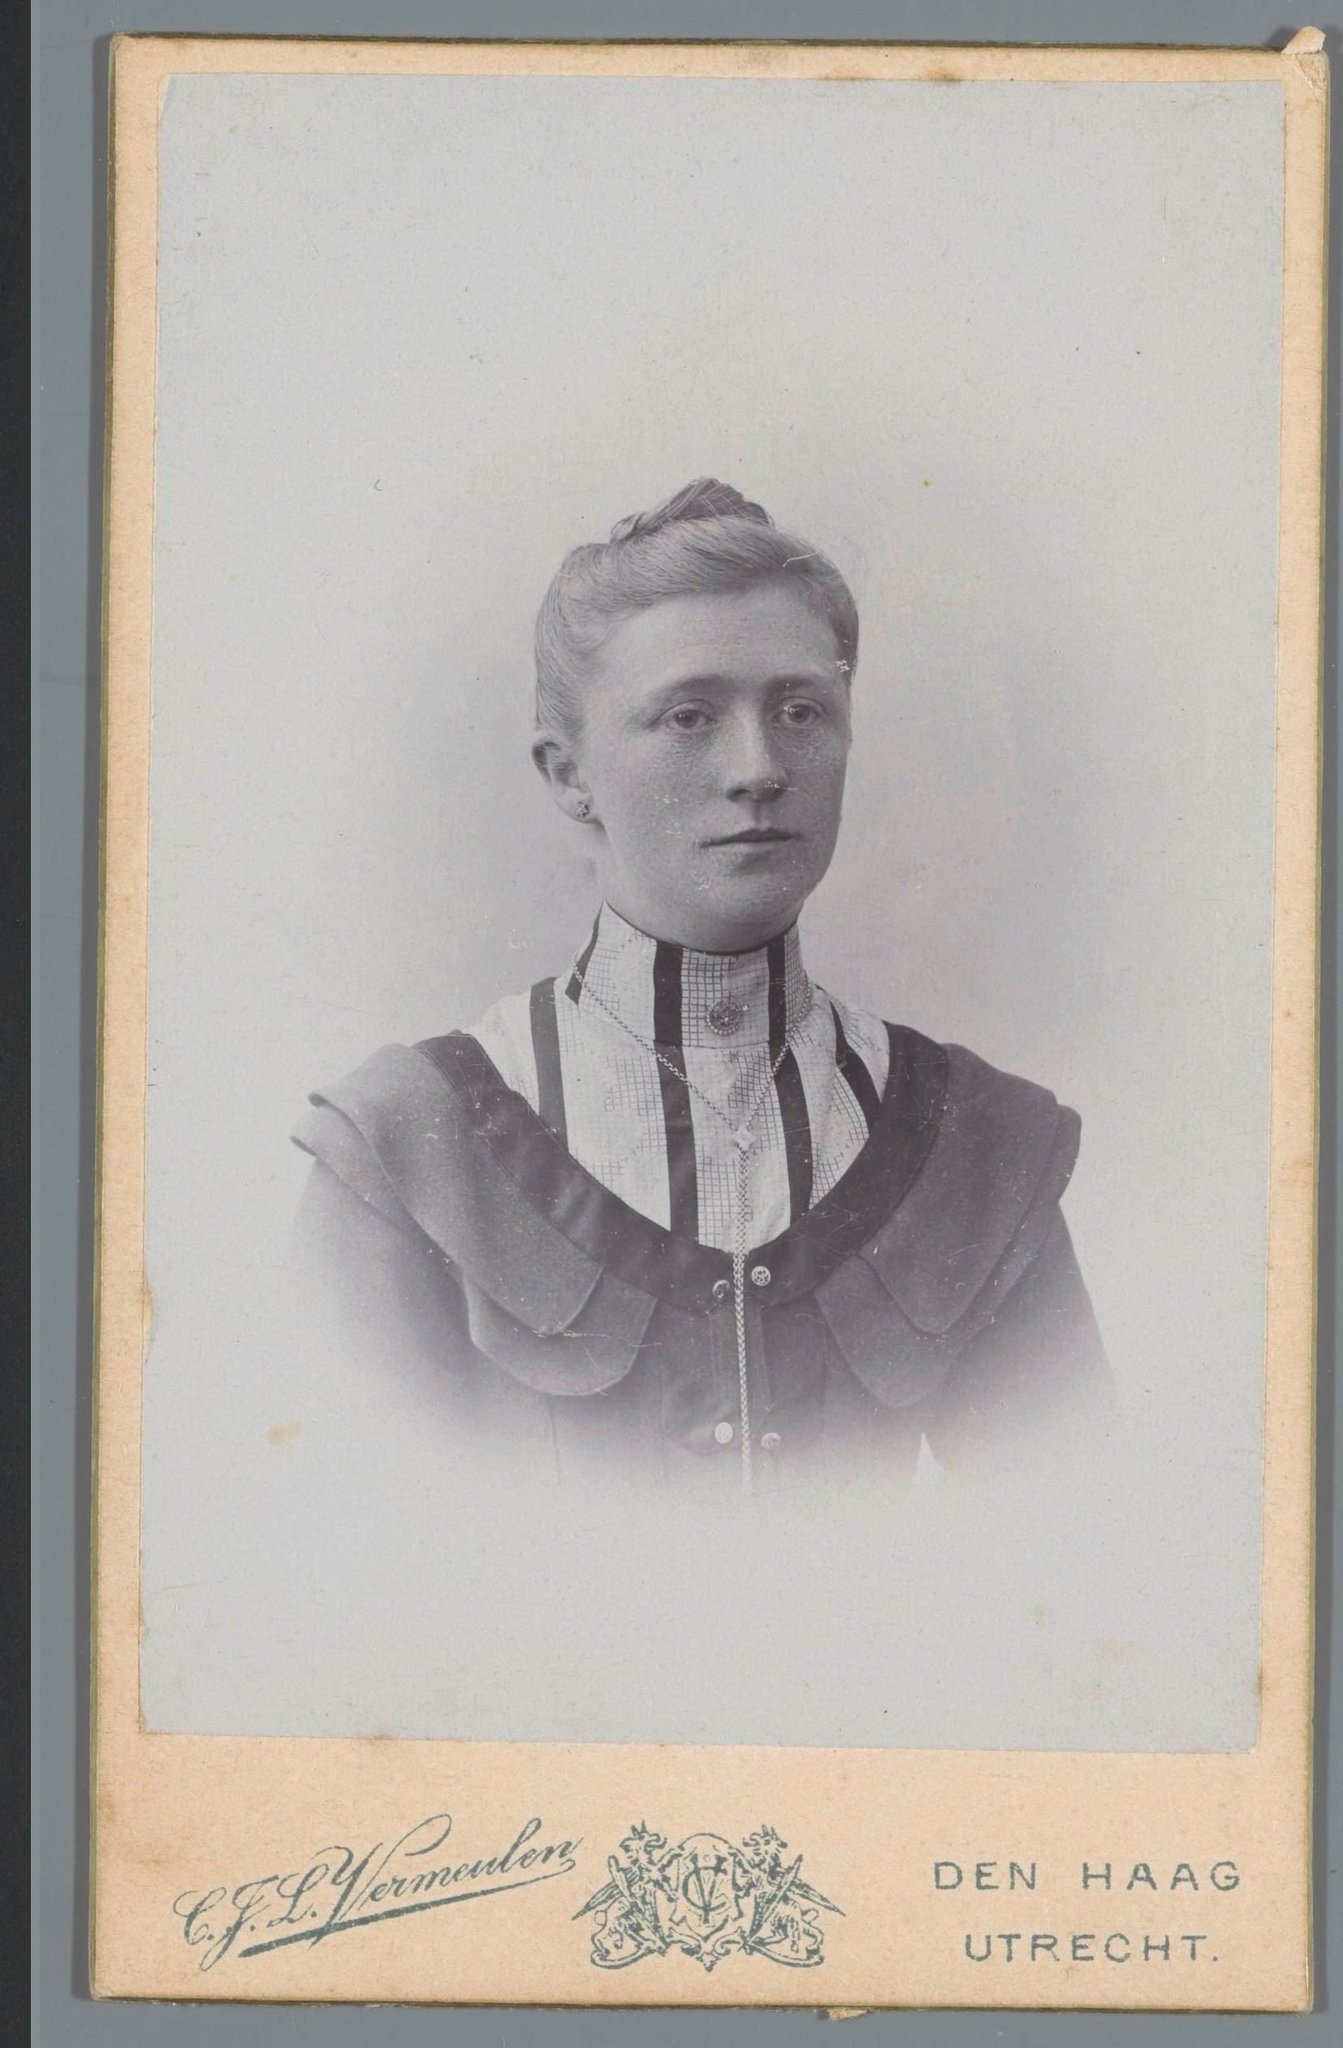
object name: carte de visite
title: Portret van een onbekende vrouw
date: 1890-1915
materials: cardboard, photographic support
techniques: daylight paper print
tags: historical persons - bb - woman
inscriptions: inscription: ‘CV/ C. J. L. Vermeulen/ DEN HAAG/ Toussaintkade 11./ Intercommunal Telephoon: 774./ AMSTERDAM/ Heiligenweg hoek Singel./ Telephoon No 2340./ UTRECHT/ Nieuwe gracht 50./ Telephoon No 750./ BLOCK & Co. BERLIN S.W.’